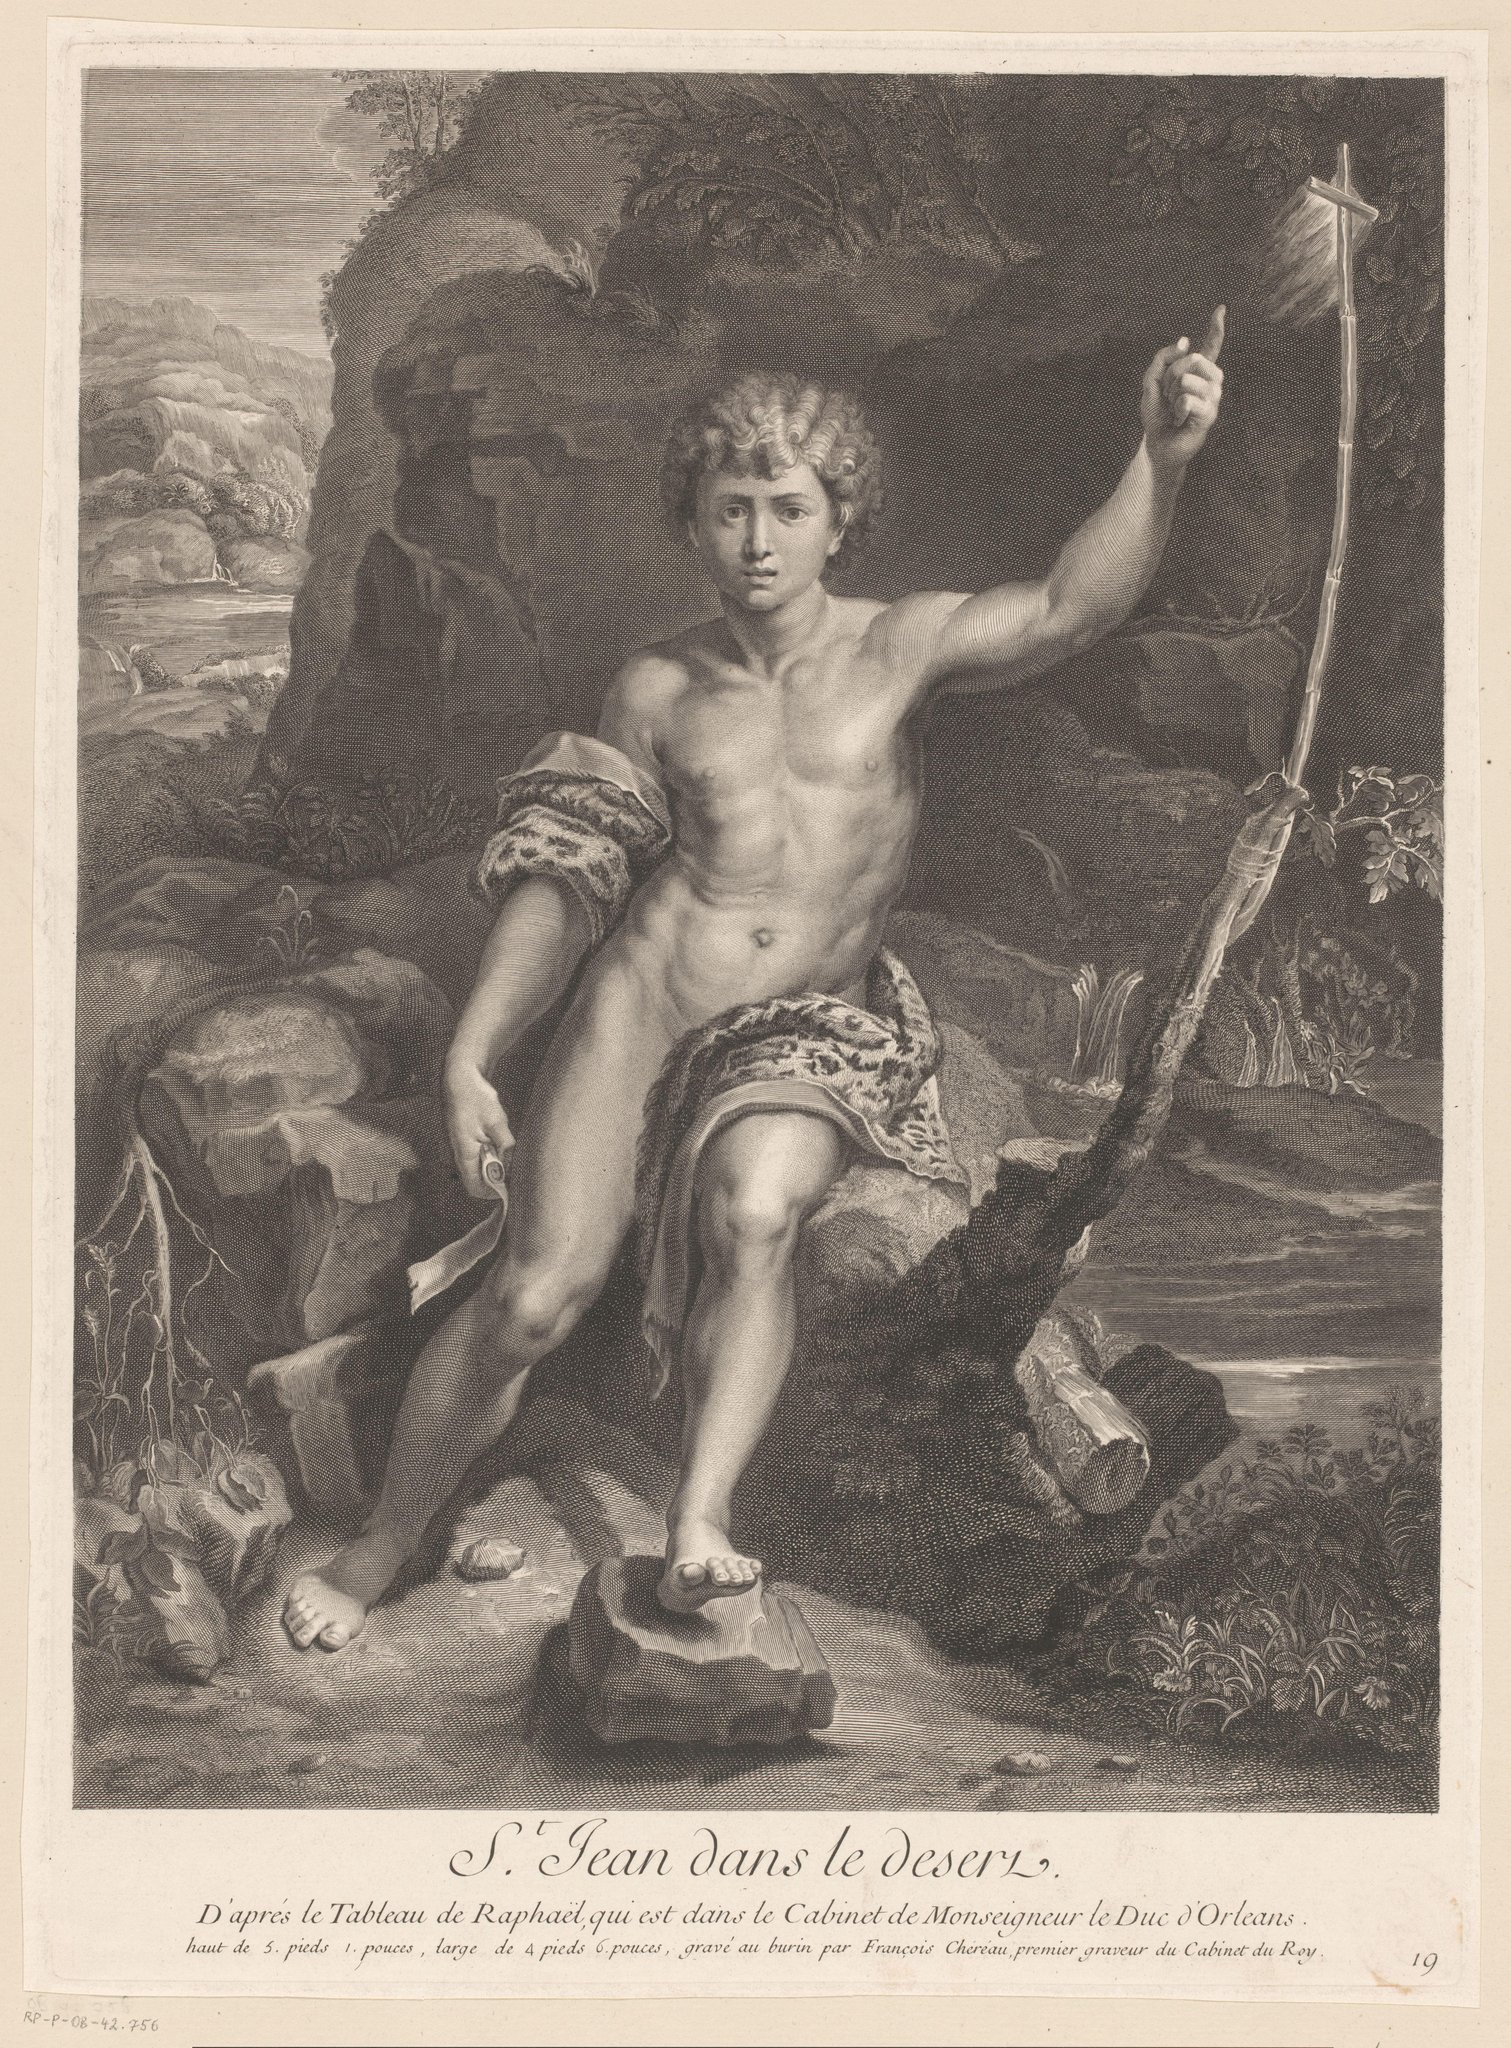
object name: print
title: Johannes de Doper in de woestijn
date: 1690-1729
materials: paper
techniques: engraving, etching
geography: france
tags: john the baptist in the wilderness, usually accompanied by a lamb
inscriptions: collector's mark: Lugt 240